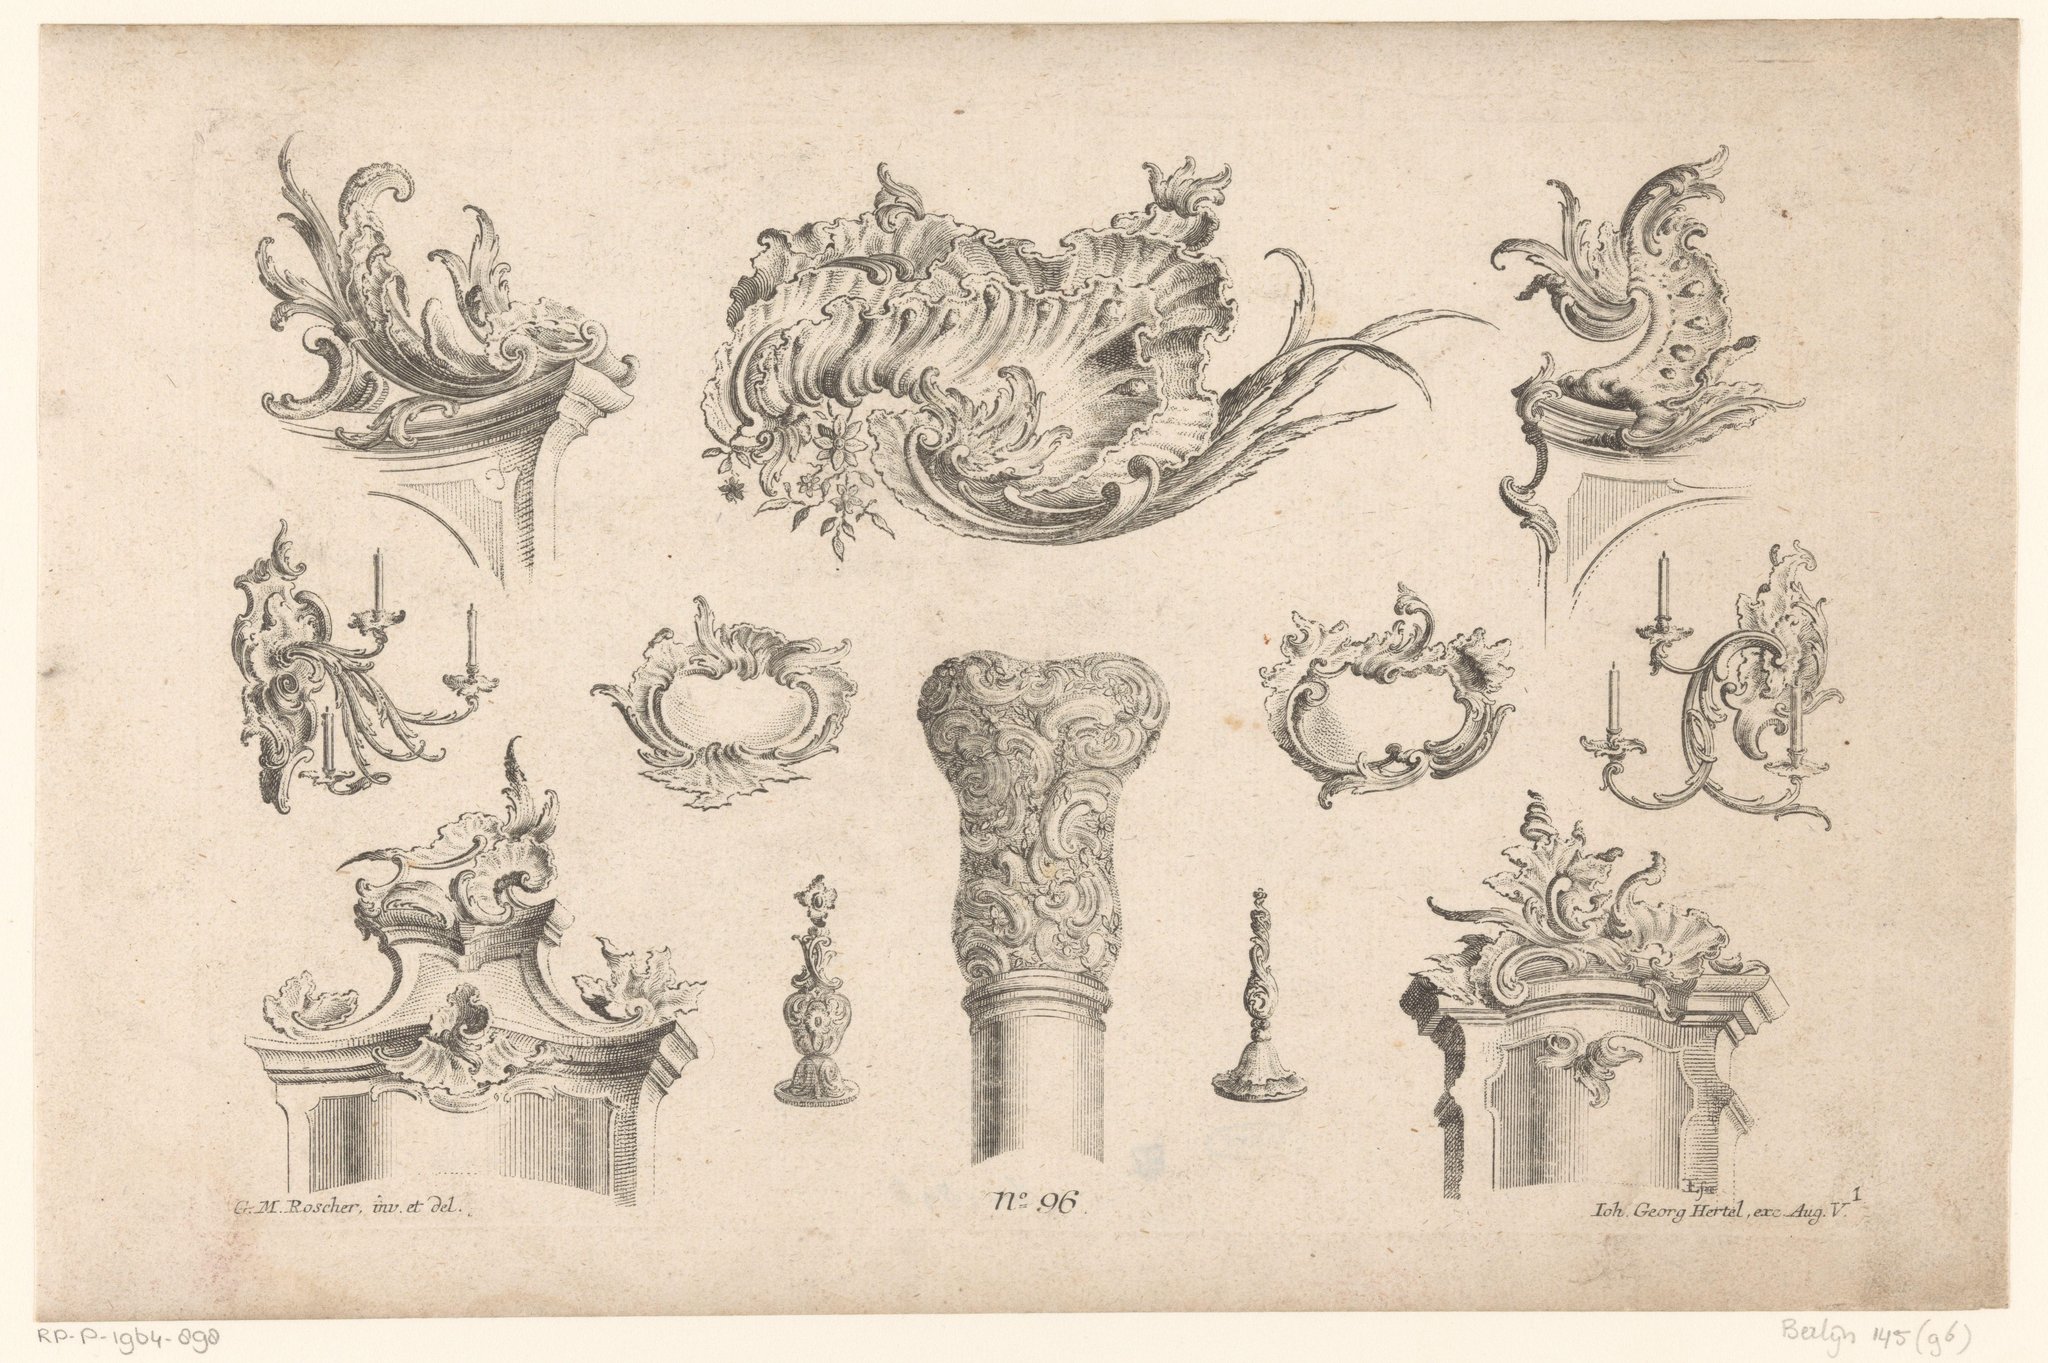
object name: ornament print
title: Rocaille motieven met stokknop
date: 1727-1775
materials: paper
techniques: etching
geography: augsburg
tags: rocaille ornament, chandelier, candelabrum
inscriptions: collector's mark: Lugt 2760, collector's mark: Lugt 2228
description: Rocaille ornamenten, twee driearmige rocaille wandkandelaars en een geornamenteerde stokknop. Uitgeversnummer 96.